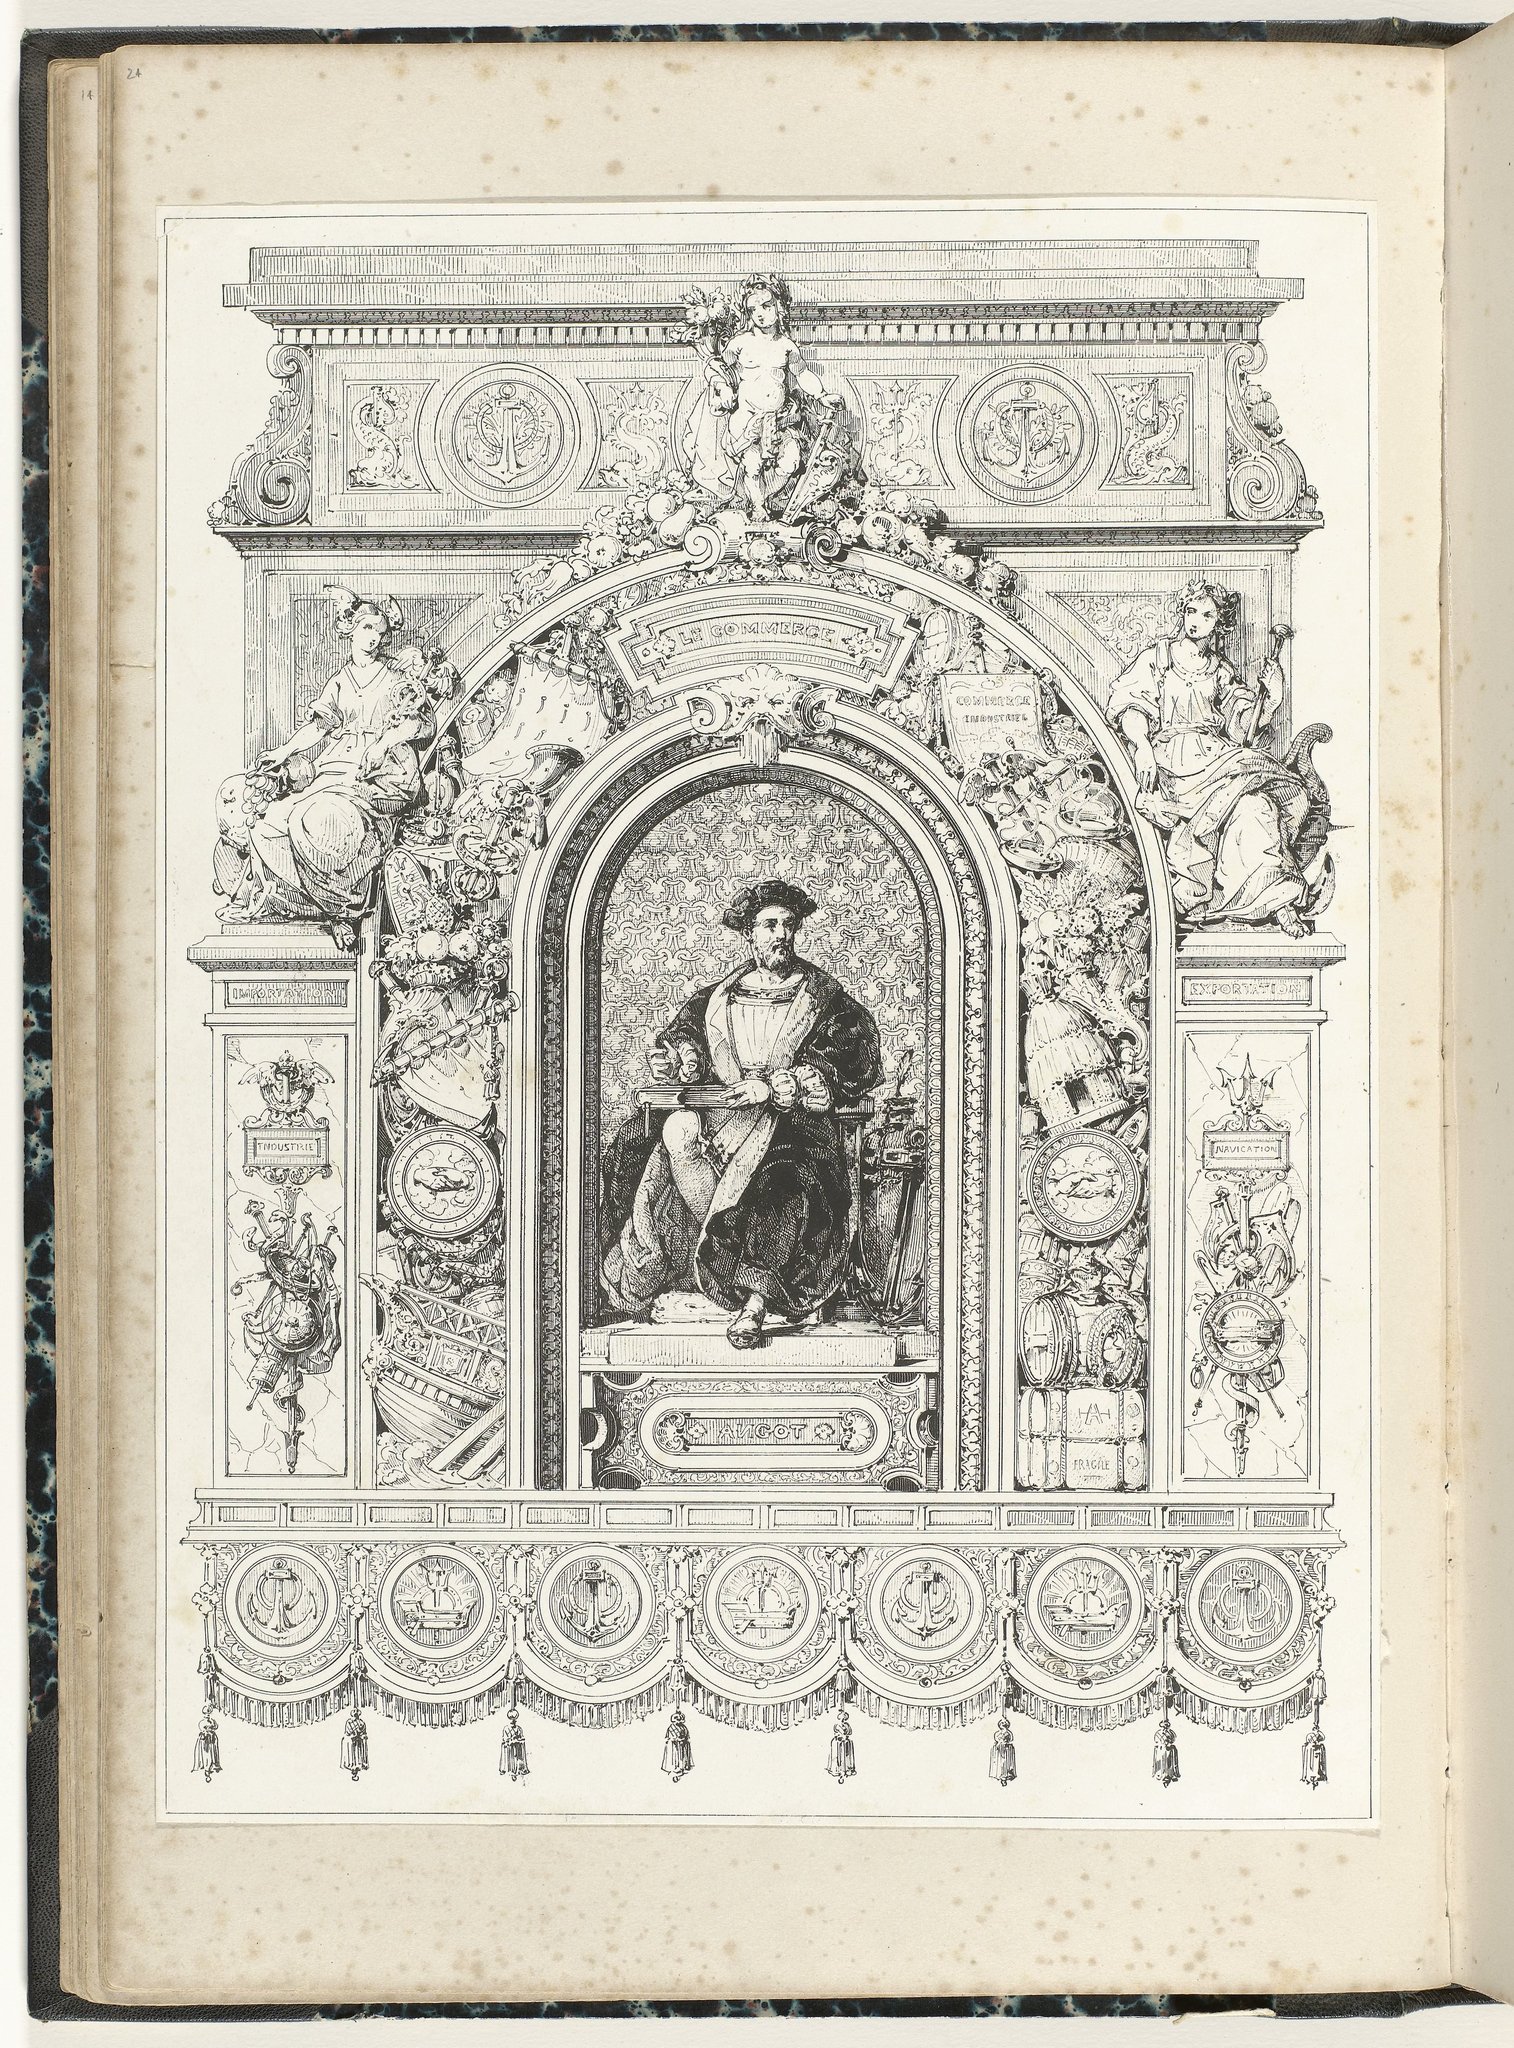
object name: print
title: Man in nis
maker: Anonymous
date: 1866-1900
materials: paper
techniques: lithograph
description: De nis bevindt zich onder een rijk gedecoreerde boog, waartegen aan de linkerkant Mercurius leunt.